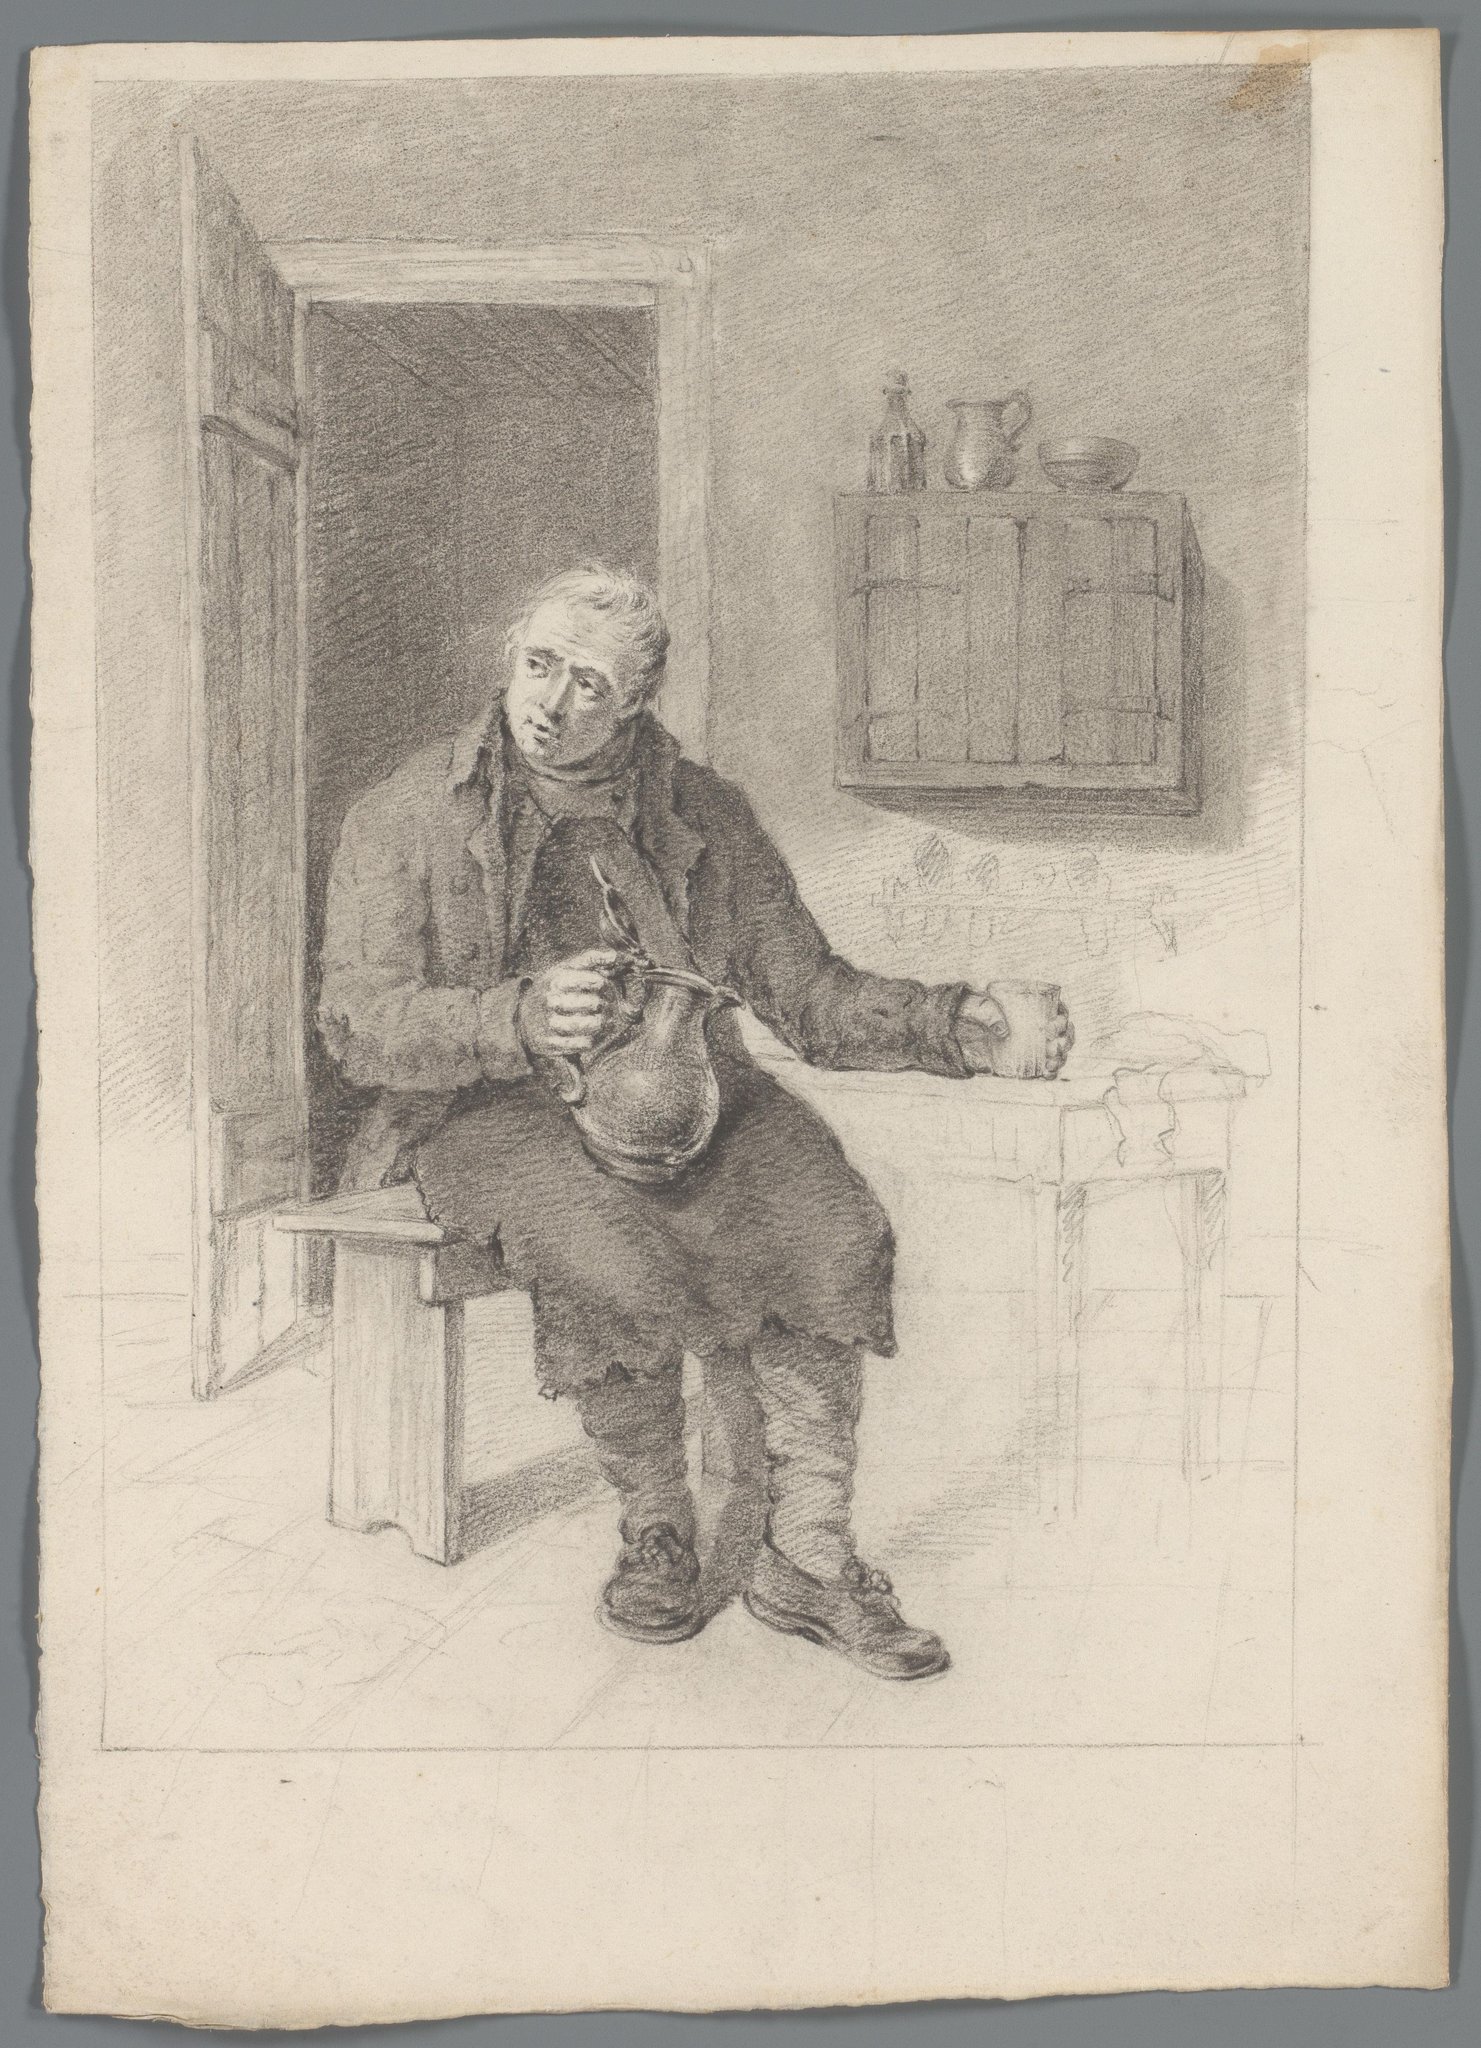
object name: drawing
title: Zittende man met een karaf en glas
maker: Anonymous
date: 1820-1830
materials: chalk, paper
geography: the hague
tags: sitting figure, adult man, drinking-vessels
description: Tekeningen waarschijnlijk ontstaan bij het Haagse kunstgenootschap ‘Tot Nut der Tekenkunst’, waar twee keer per week tekenavonden werden georganiseerd met geklede modellen.